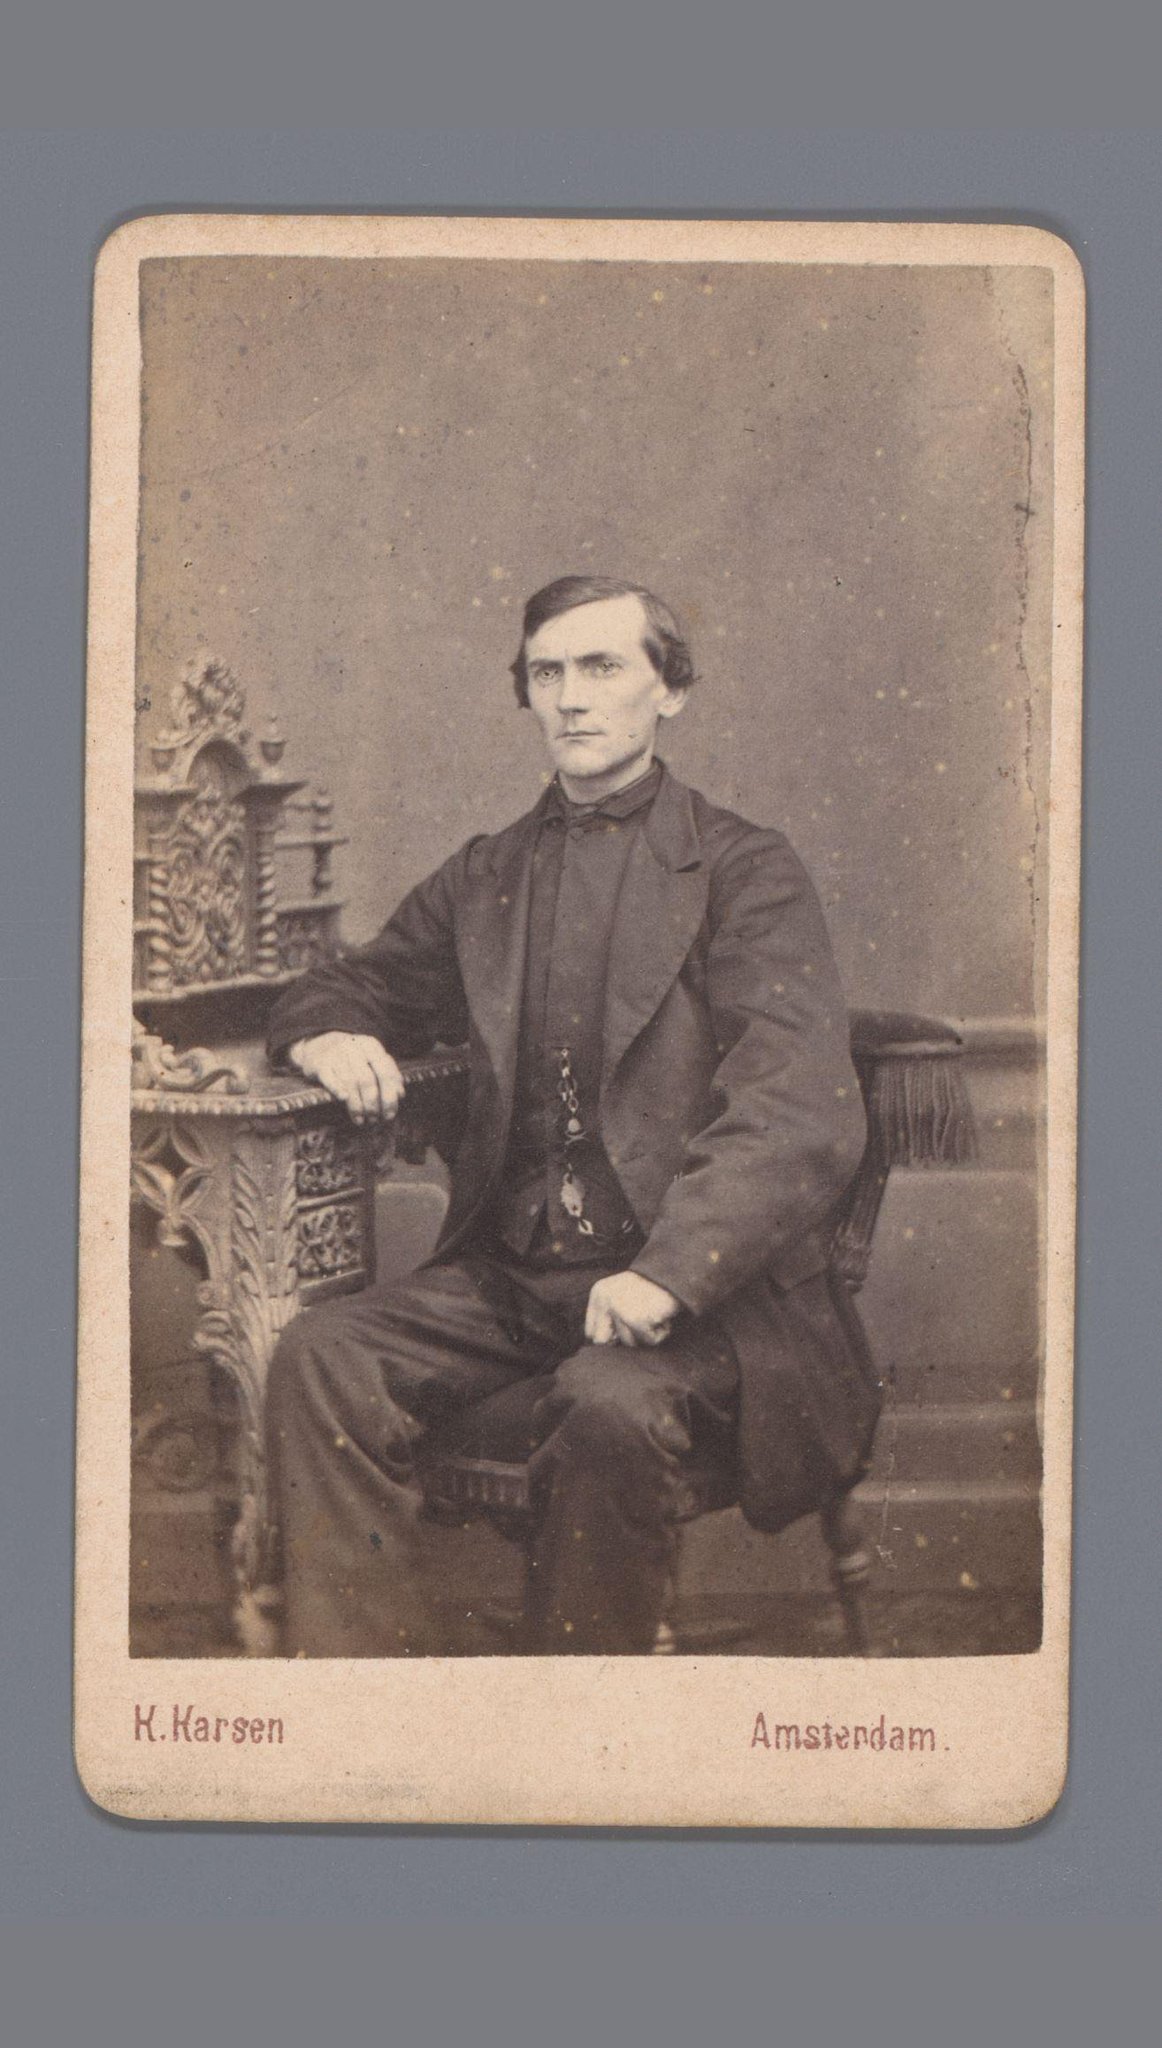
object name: carte de visite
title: Portret van een onbekende man, zittend aan een bureau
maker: kasparus karsen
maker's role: draughtsman, painter, print maker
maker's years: 1810-1896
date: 1864-1896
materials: cardboard, paper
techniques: albumen print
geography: amsterdam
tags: writing-table, writing-desk, sitting figure, adult man, historical persons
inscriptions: inscription: ‘Photographie/ K. KARSEN/ Kunstschilder en Photograaf/ AMSTERDAM/ Nieuwendijk. H. No. 4.’